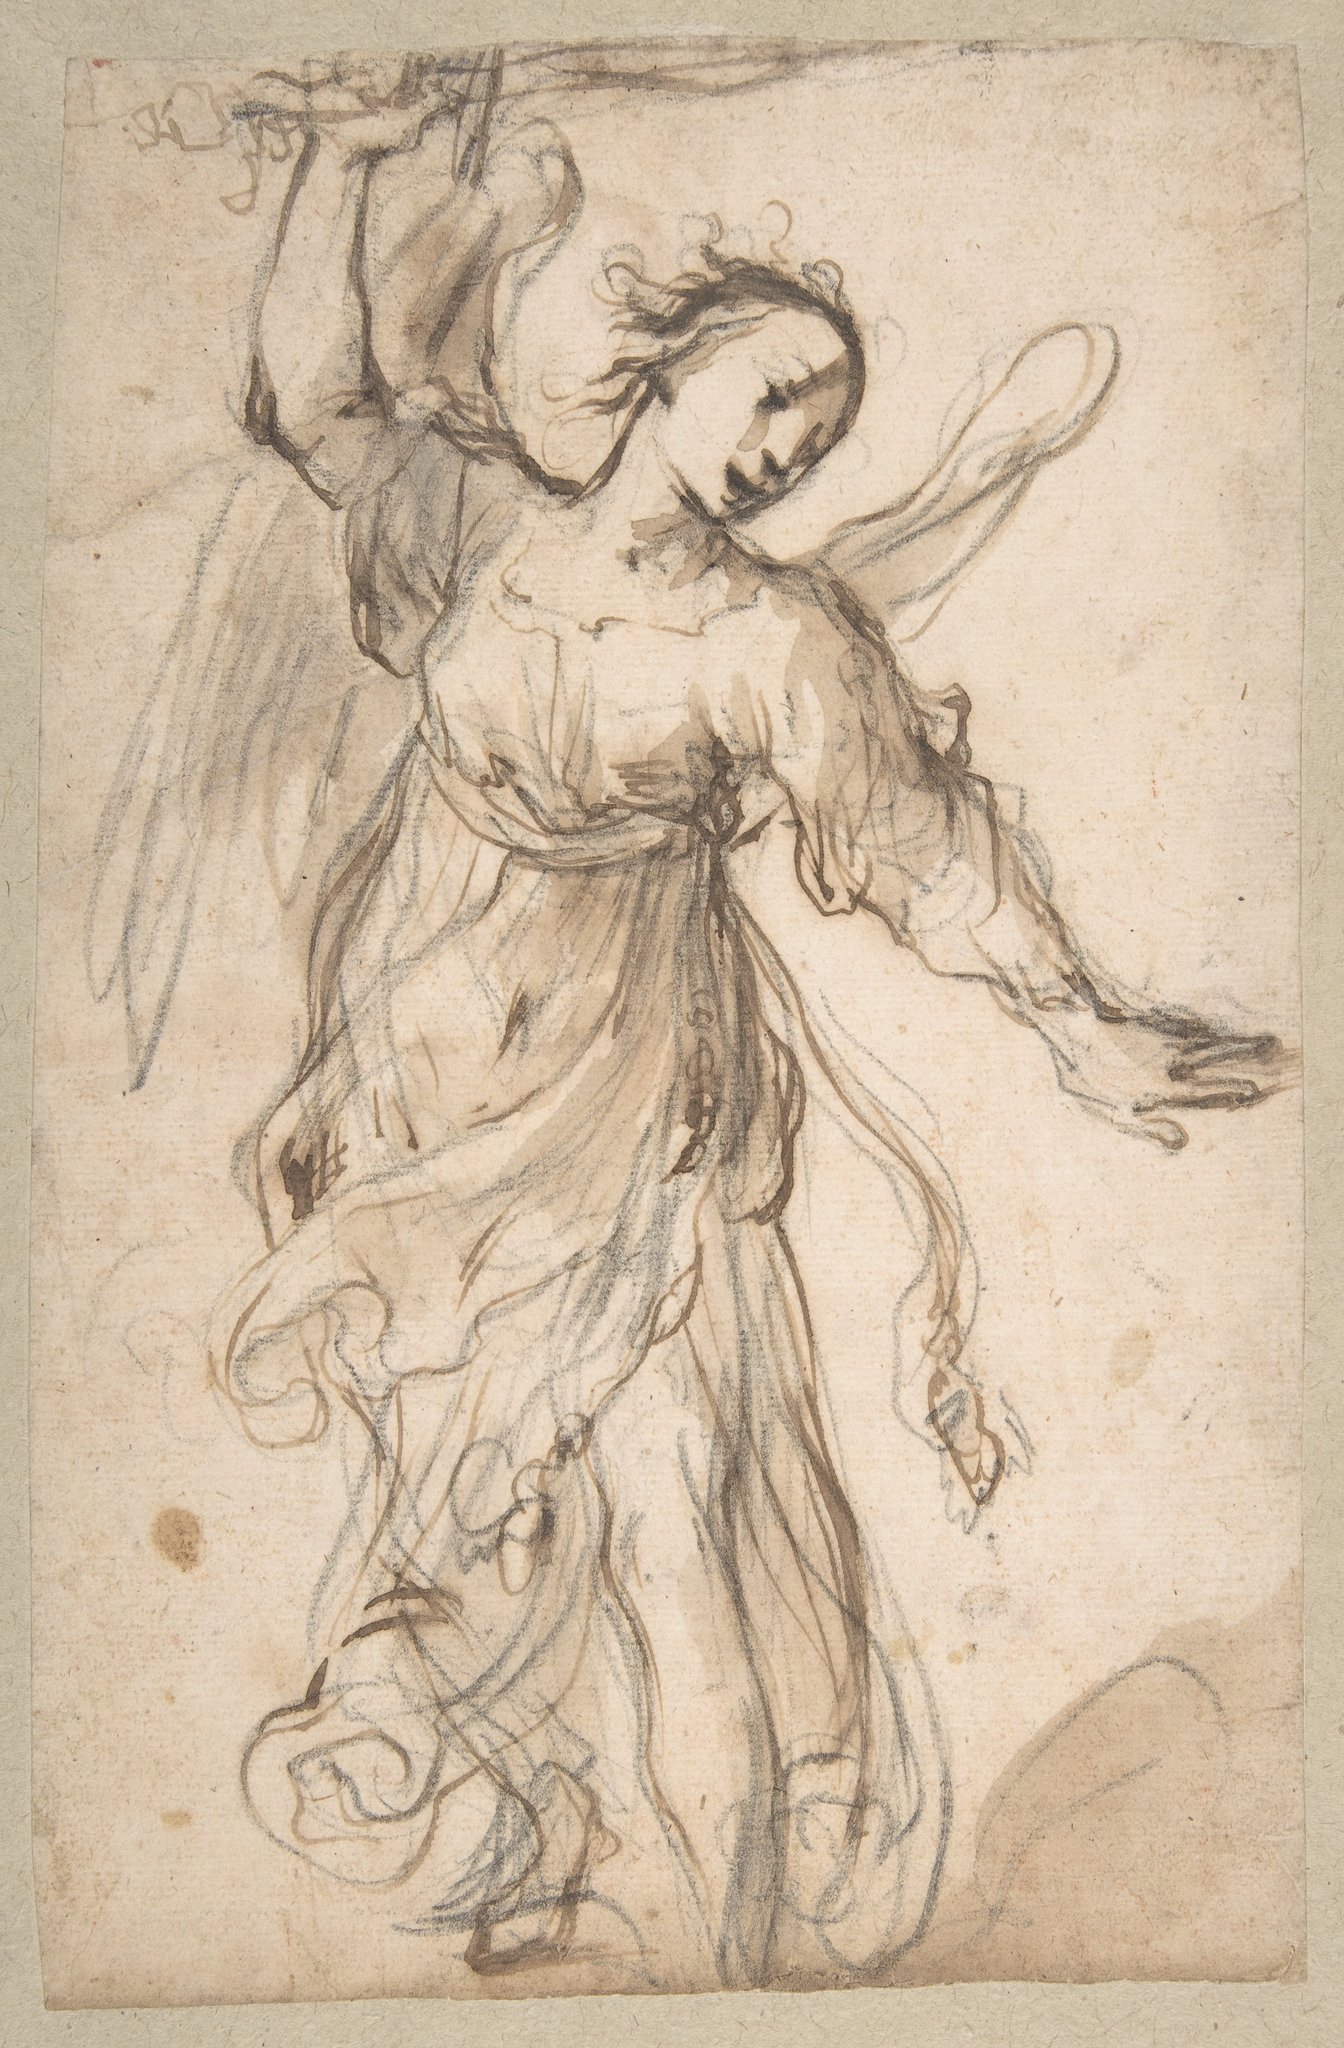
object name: drawing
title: Standing Angel Brandishing a Sword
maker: ferraù fenzoni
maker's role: artist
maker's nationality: italian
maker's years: 1562-1645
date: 1590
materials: chalk, ink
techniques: brush, pen, wash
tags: swords,angels